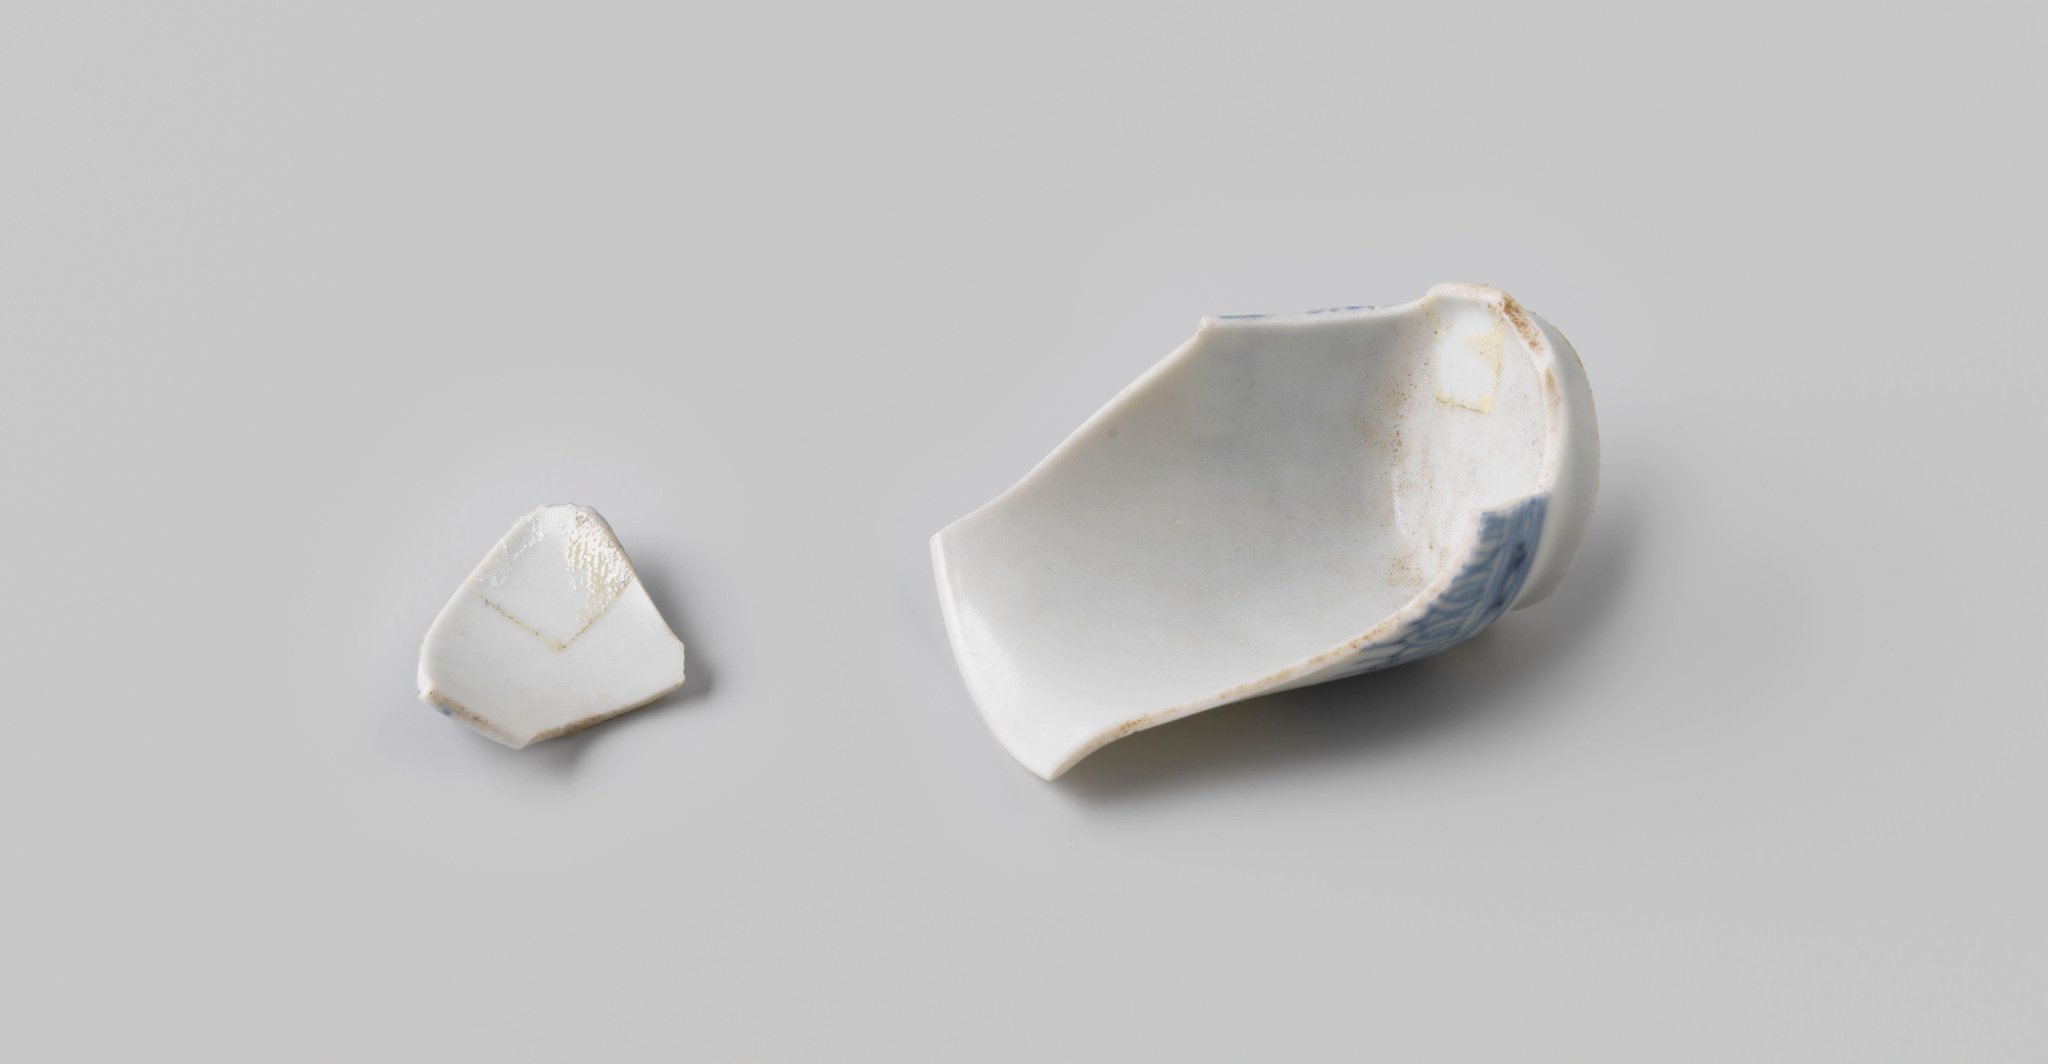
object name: wine cup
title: Scherven van een wijnkom uit V.O.C.-schip de 'Witte Leeuw'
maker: Anonymous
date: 1613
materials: porcelain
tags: verenigde oostindische compagnie, sint-helena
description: Scherven van een wijnkom uit V.O.C.-schip de 'Witte Leeuw'.